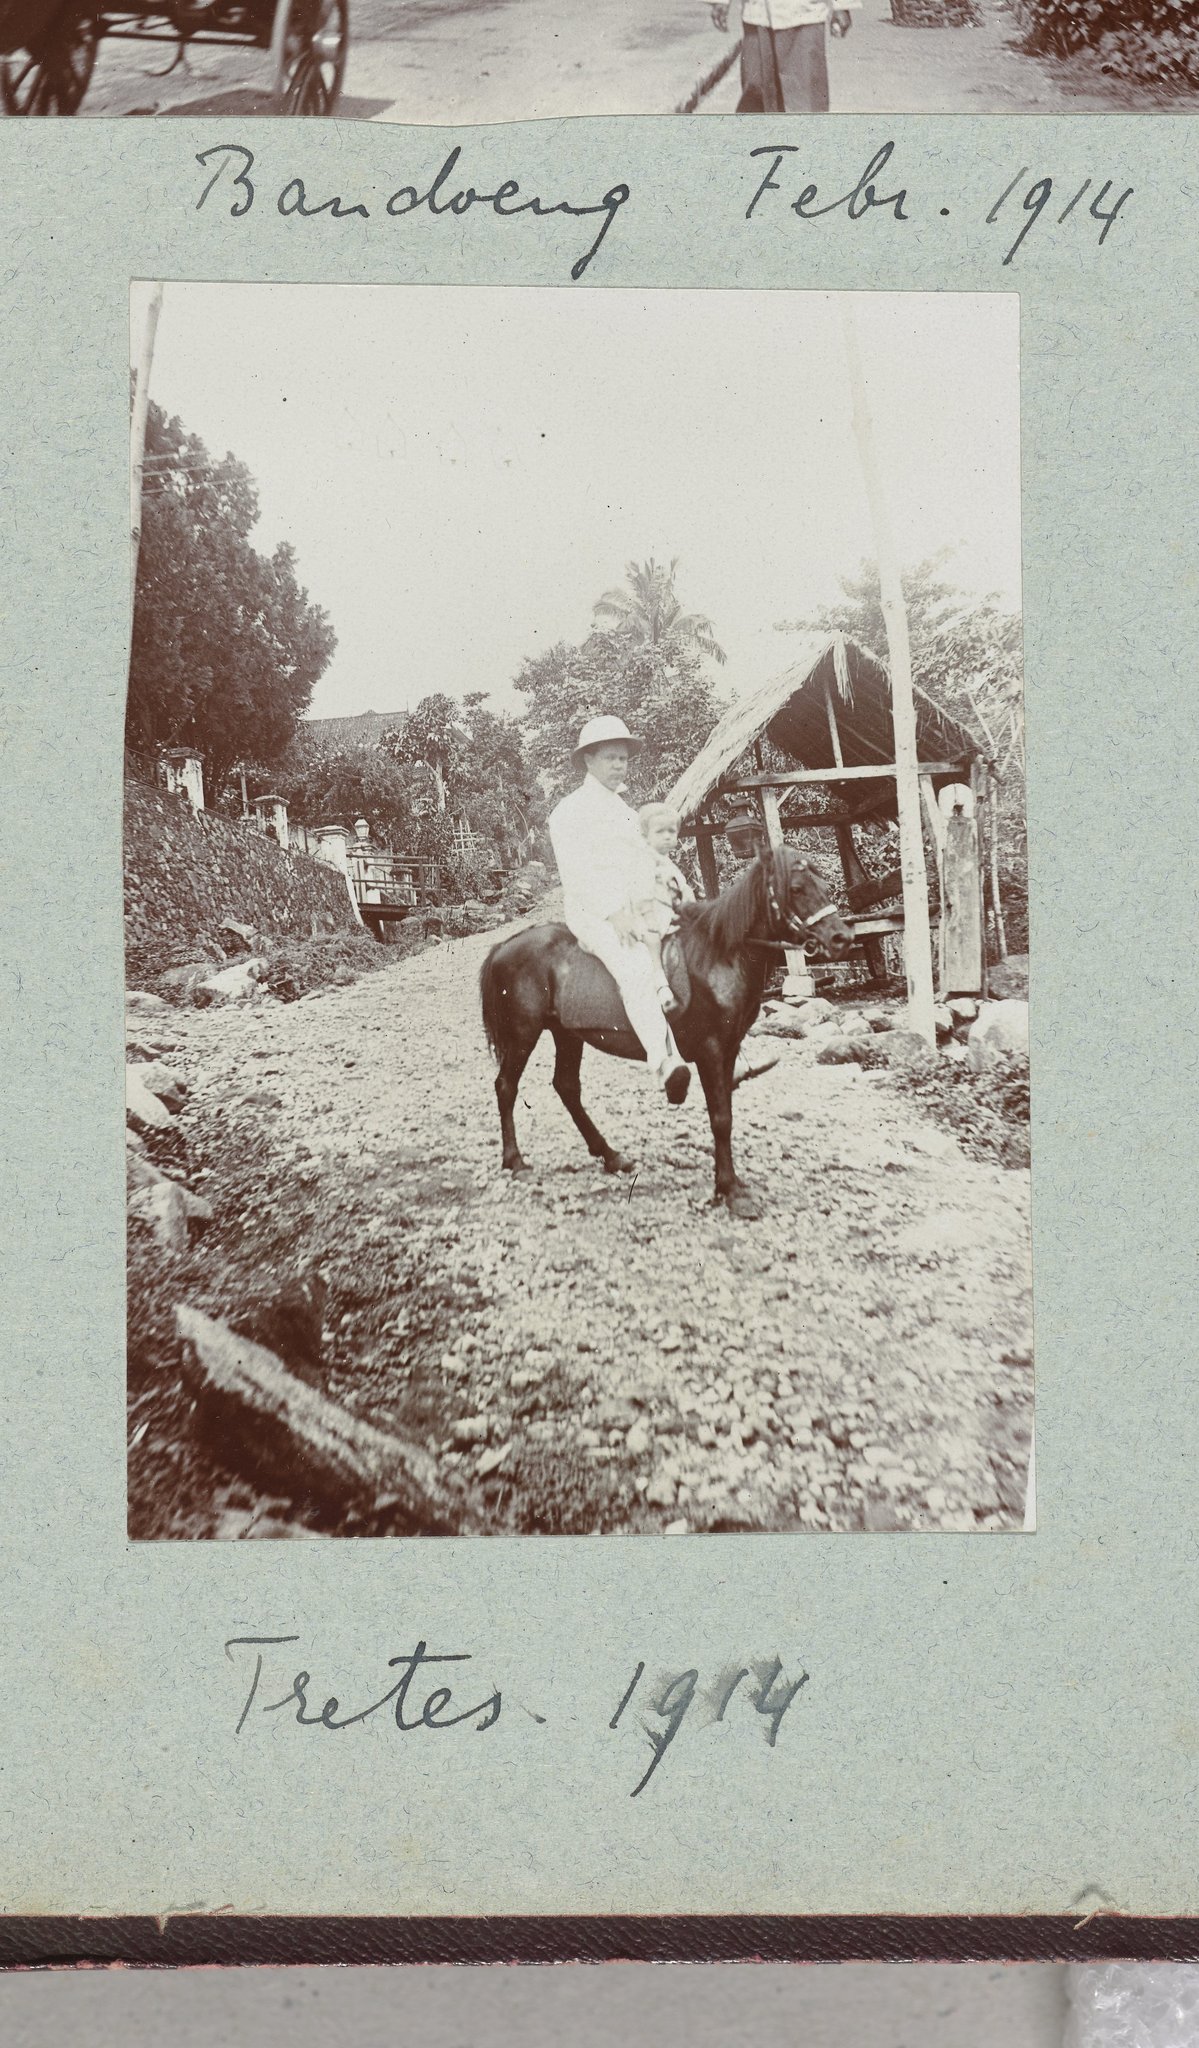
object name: photograph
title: Man in een wit tropenpak op een paardje in het Indonesische landschap.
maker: frits freerks fontein fz.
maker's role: fotograaf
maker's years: 1882-1928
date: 1912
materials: cardboard, paper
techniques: gelatin silver print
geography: madura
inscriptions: caption: ‘Kalianget 1914’